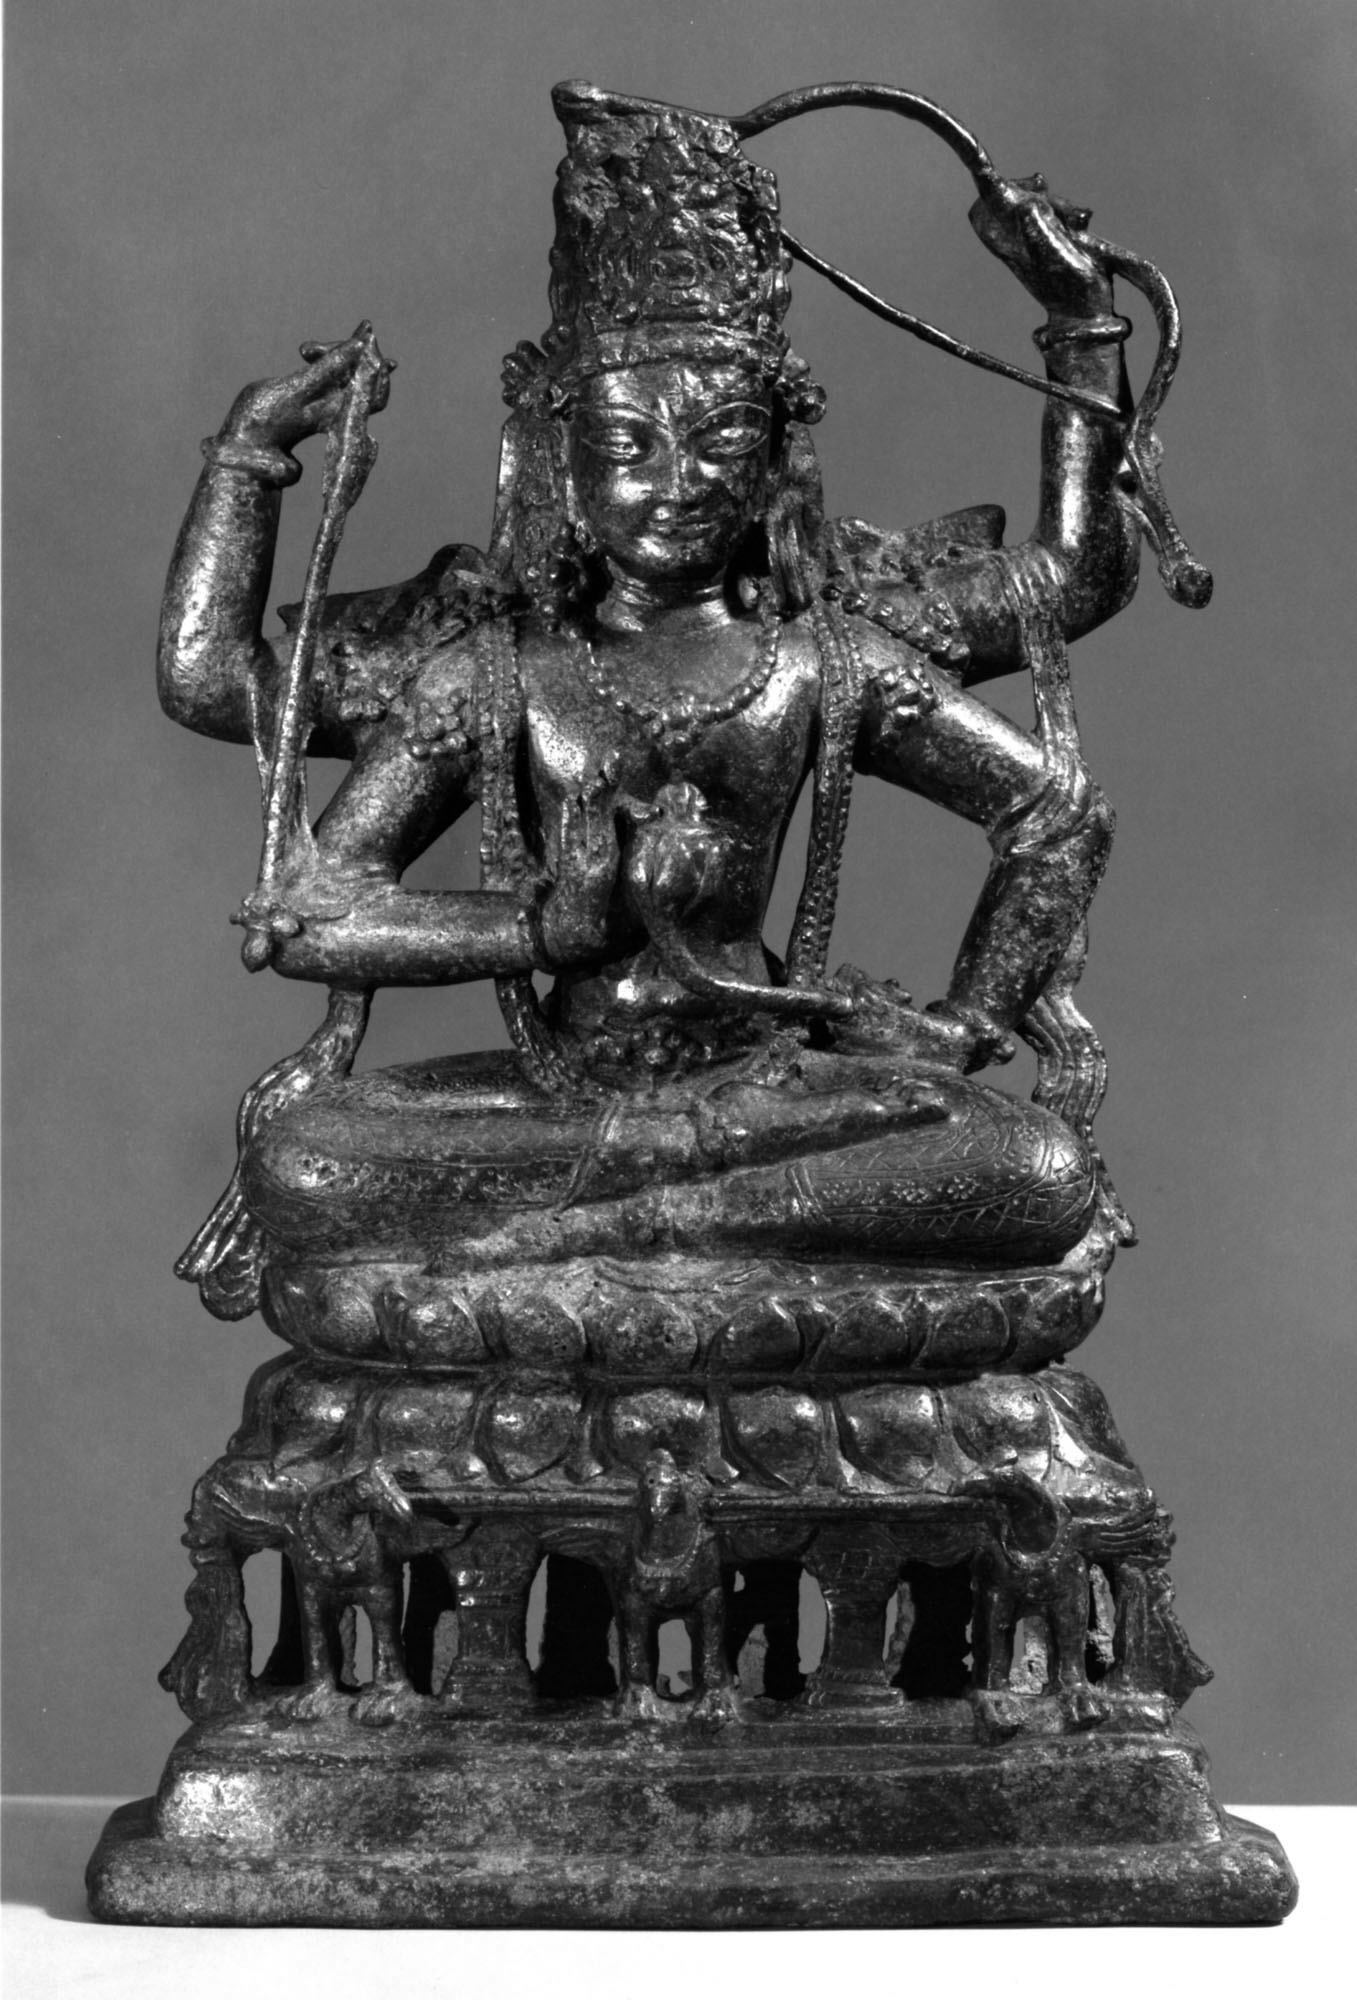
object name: figure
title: Vajradharma Lokeshvara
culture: pakistani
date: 801-900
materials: bronze, silver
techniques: inlay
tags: swat valley,bow and arrow,buddhism,bodhisattvas